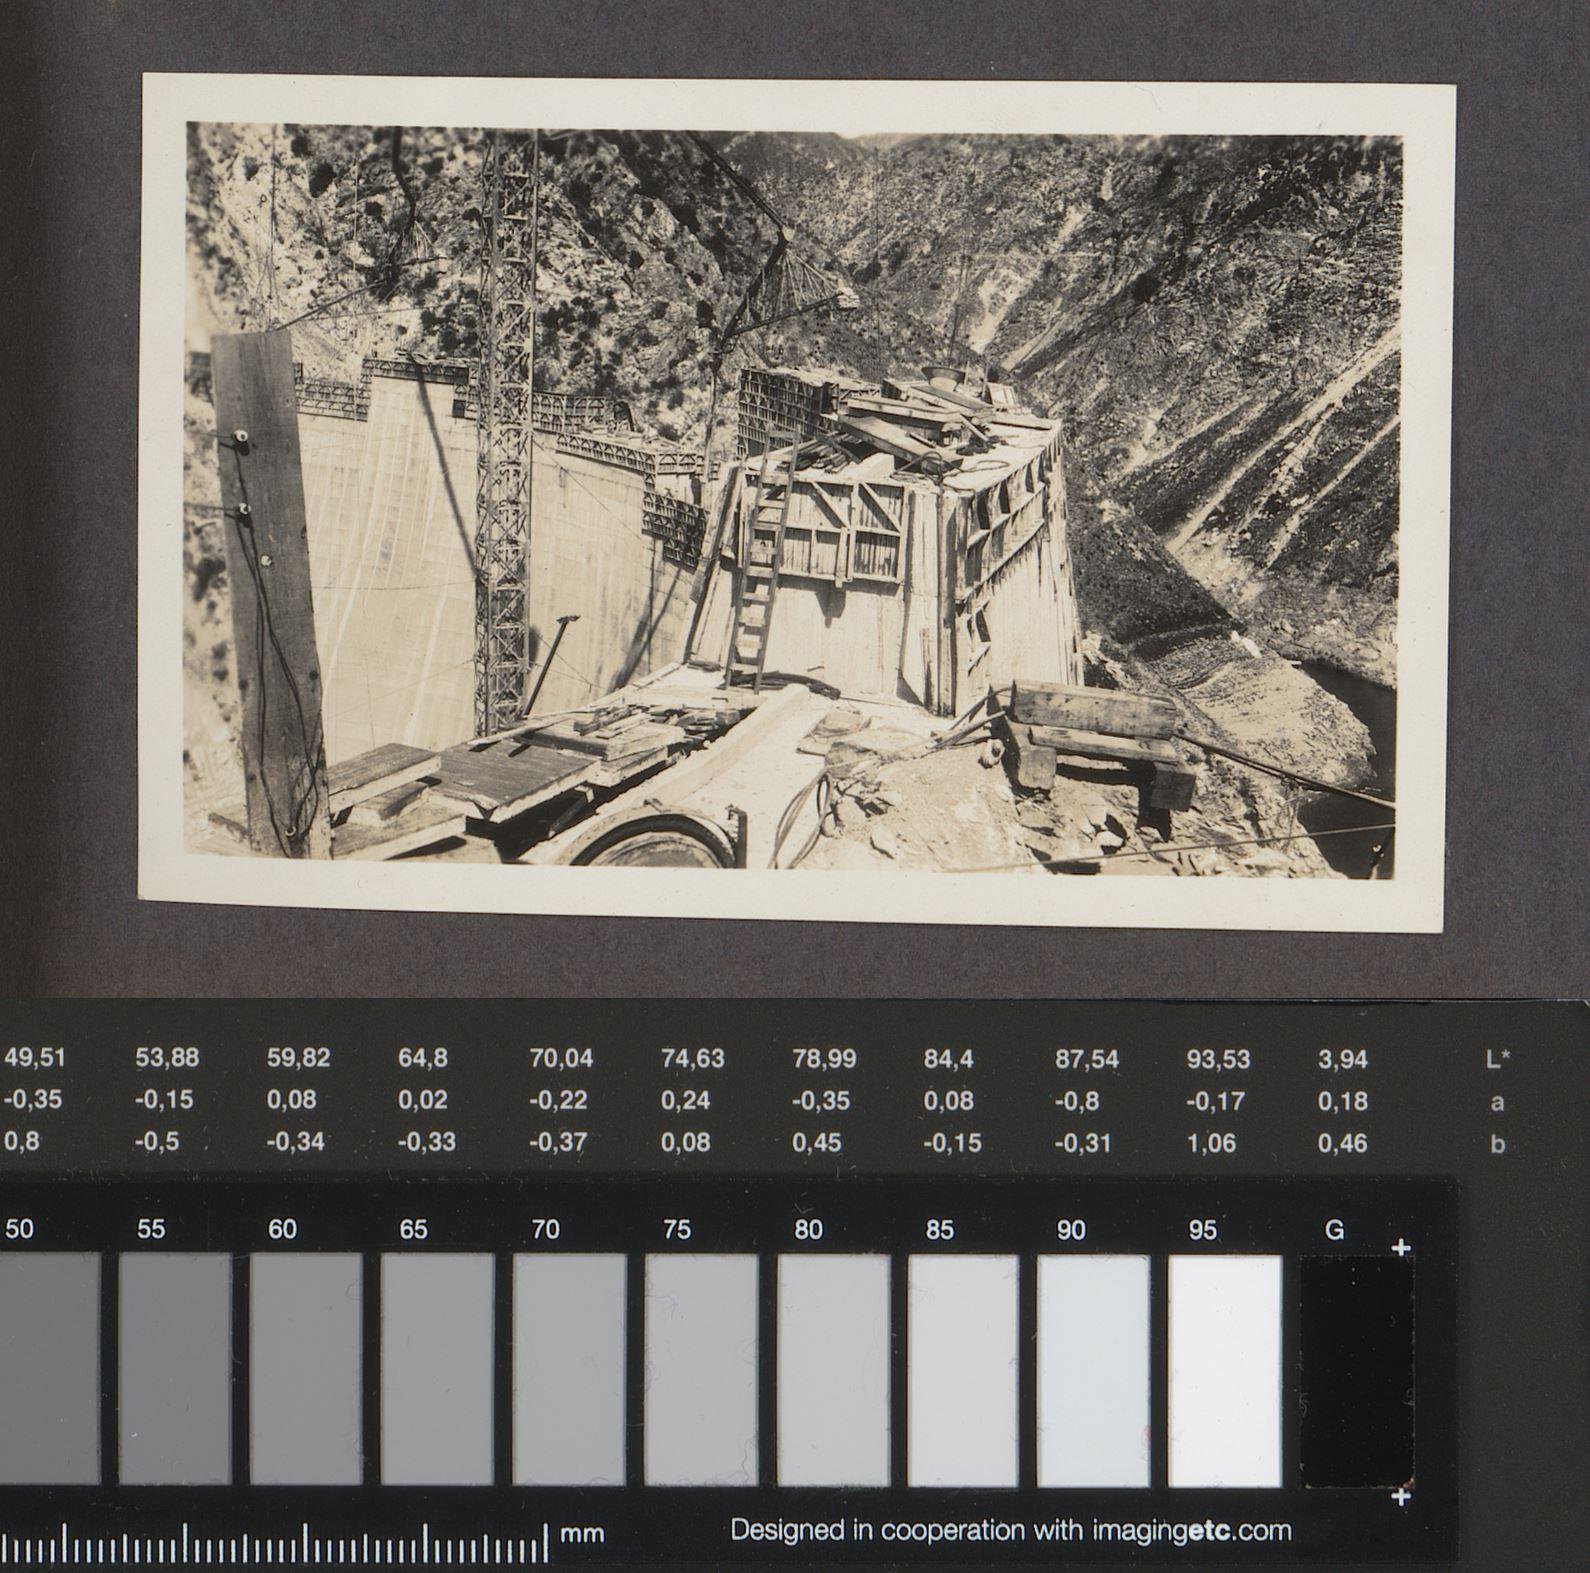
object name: album leaf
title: Pacoima Dam in aanbouw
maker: Anonymous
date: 1928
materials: photographic support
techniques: gelatin silver print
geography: los angeles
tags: machines; parts of machines; tools and appliances, dam (in canal), mountains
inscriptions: annotation: ‘Pacoima dam’